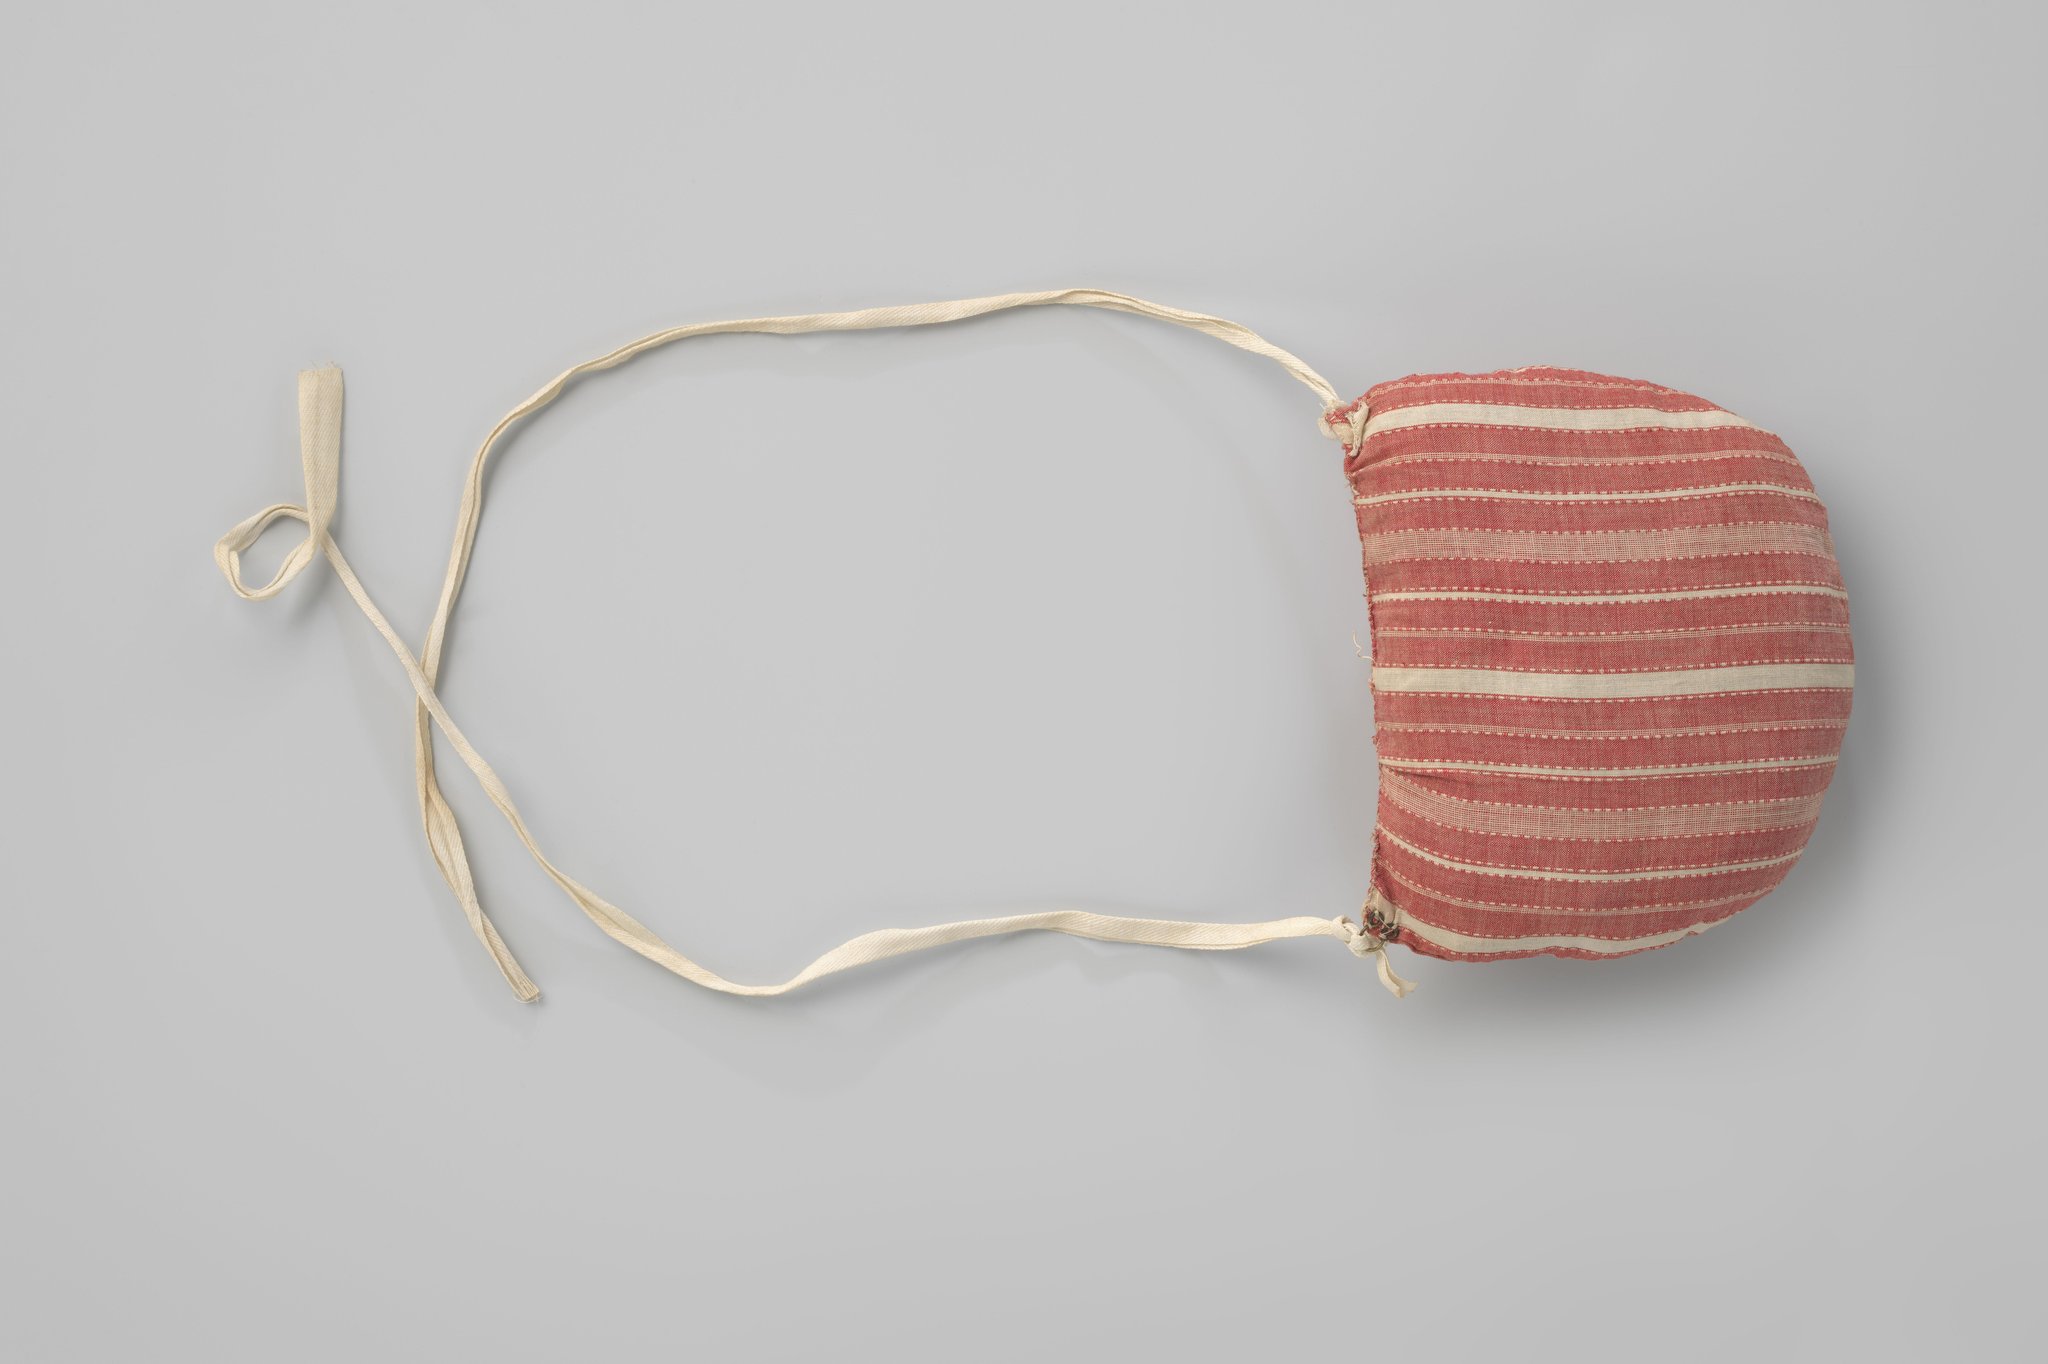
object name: tournure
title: Bustle pad from striped red and white linen-cotton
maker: Anonymous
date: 1870-1890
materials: cotton, hair, linen, ribbon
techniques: weave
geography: europe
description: De tournure is gevuld met paardenhaar en voorzien van twee linten.